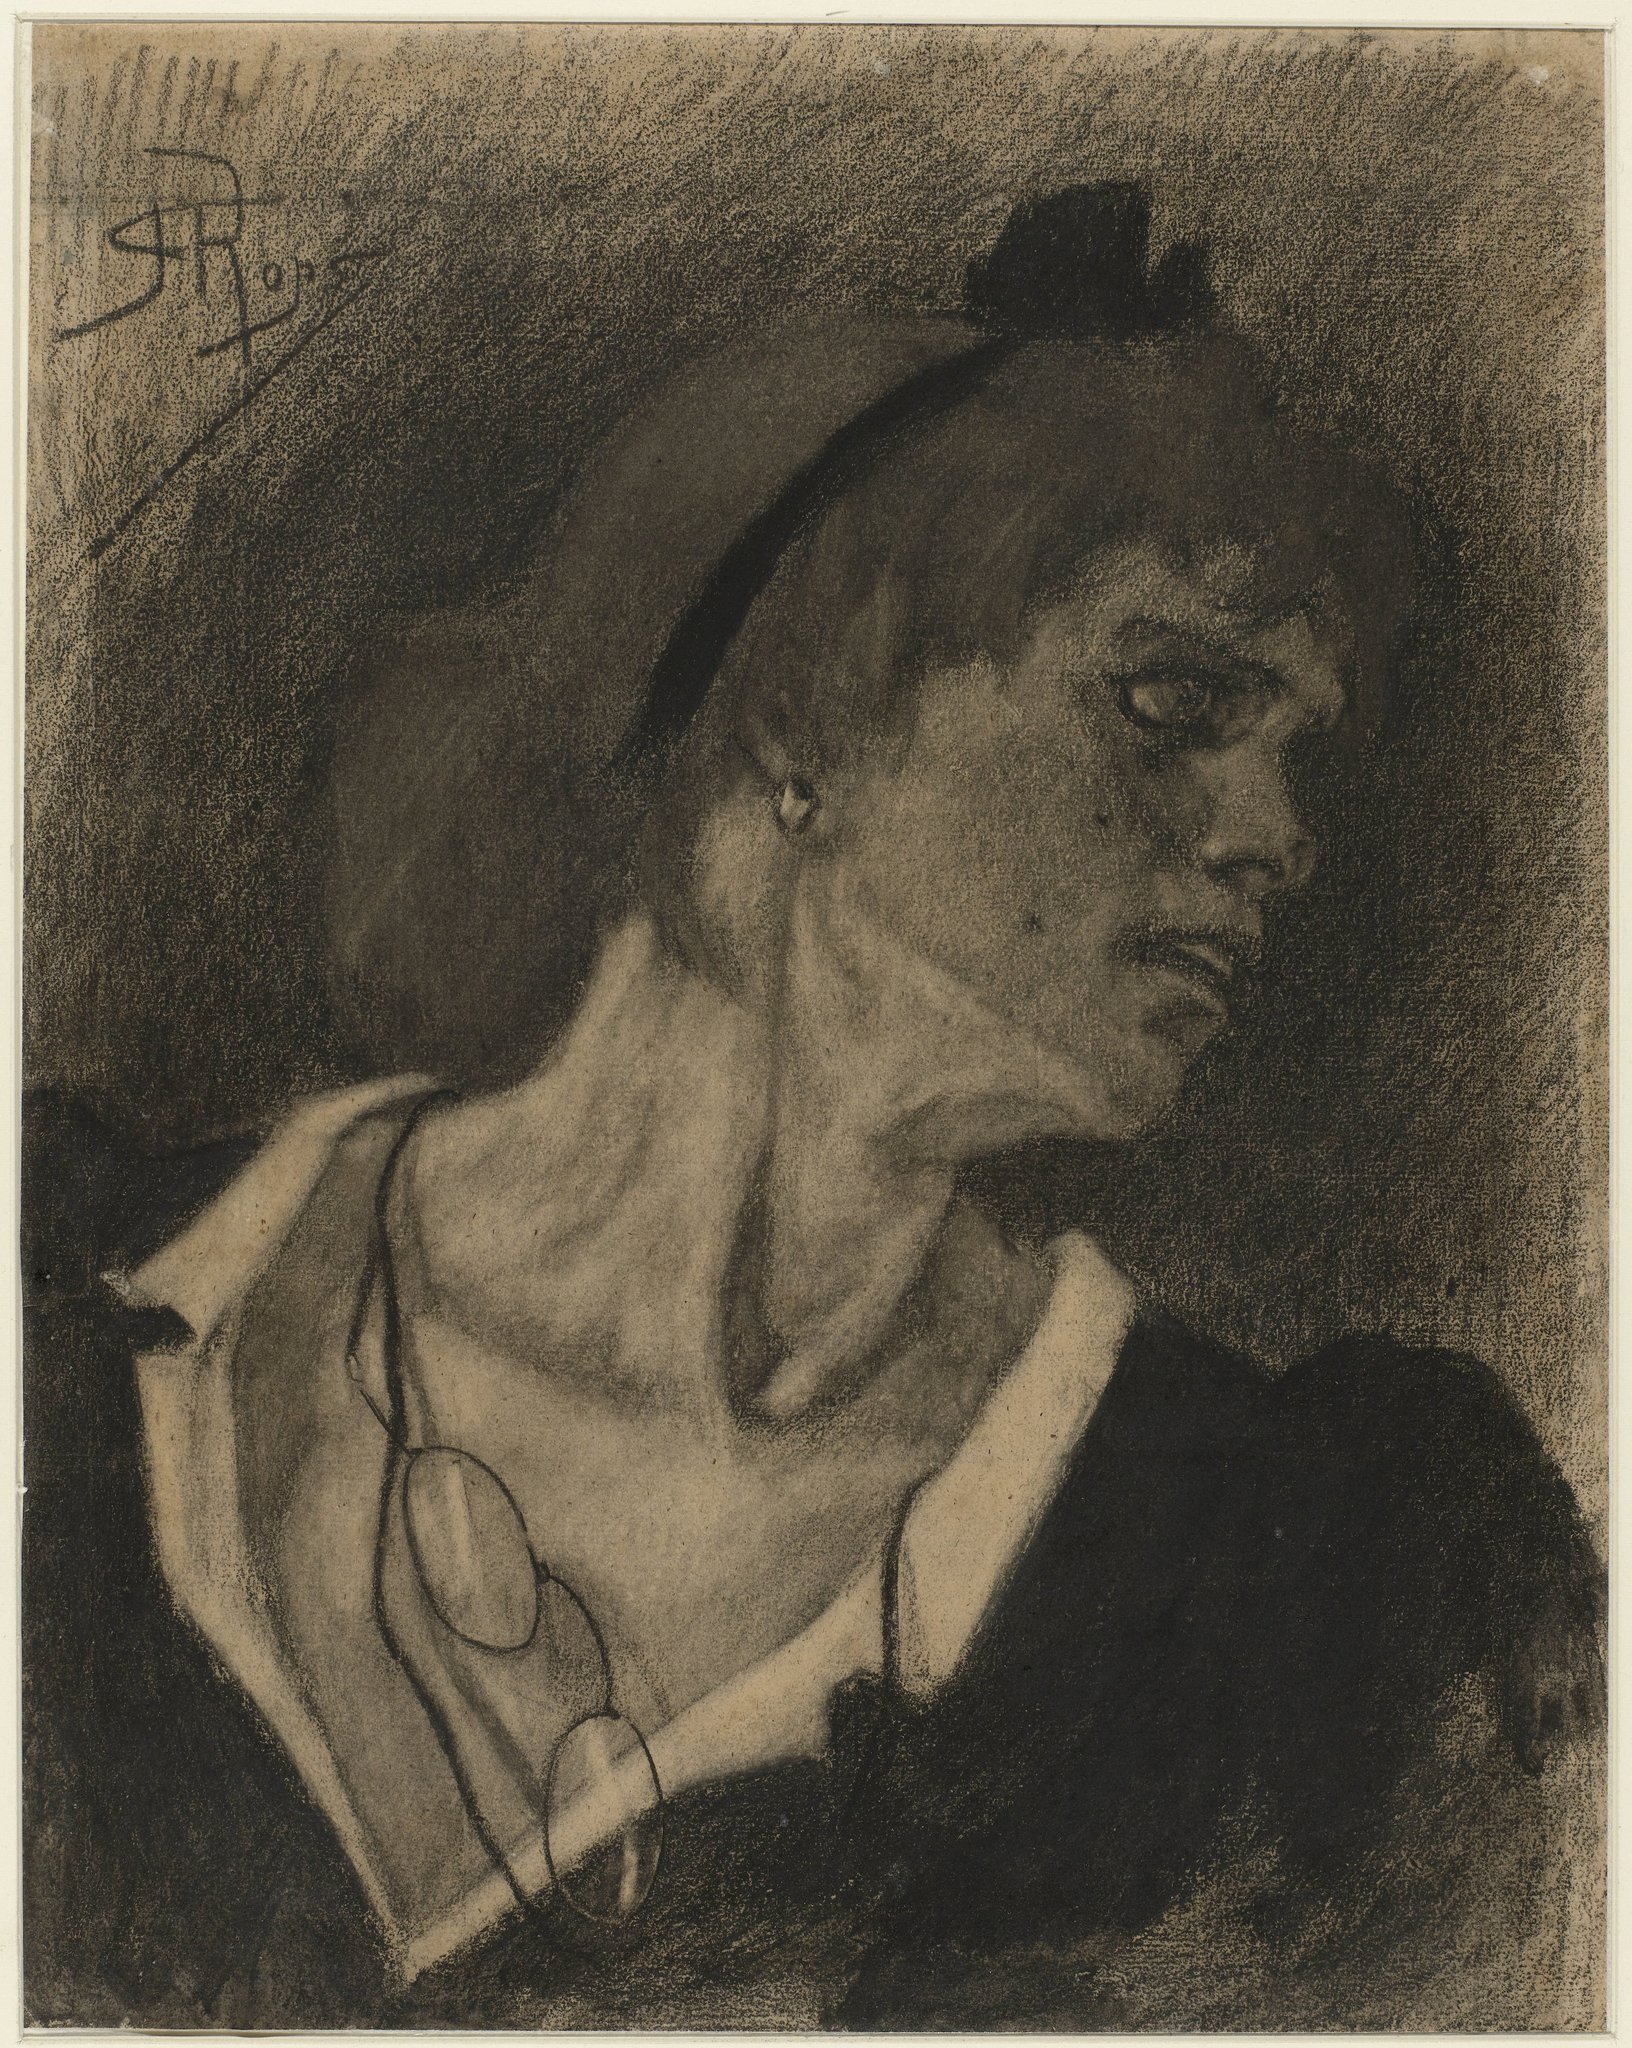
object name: drawing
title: Borstbeeld van een vrouw met lorgnet aan een snoer om de hals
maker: félicien rops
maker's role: draughtsman, print maker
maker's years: 1833-1898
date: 1843-1898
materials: chalk, paper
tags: eyeglasses, spectacles - aa - female human figure, female sex; woman